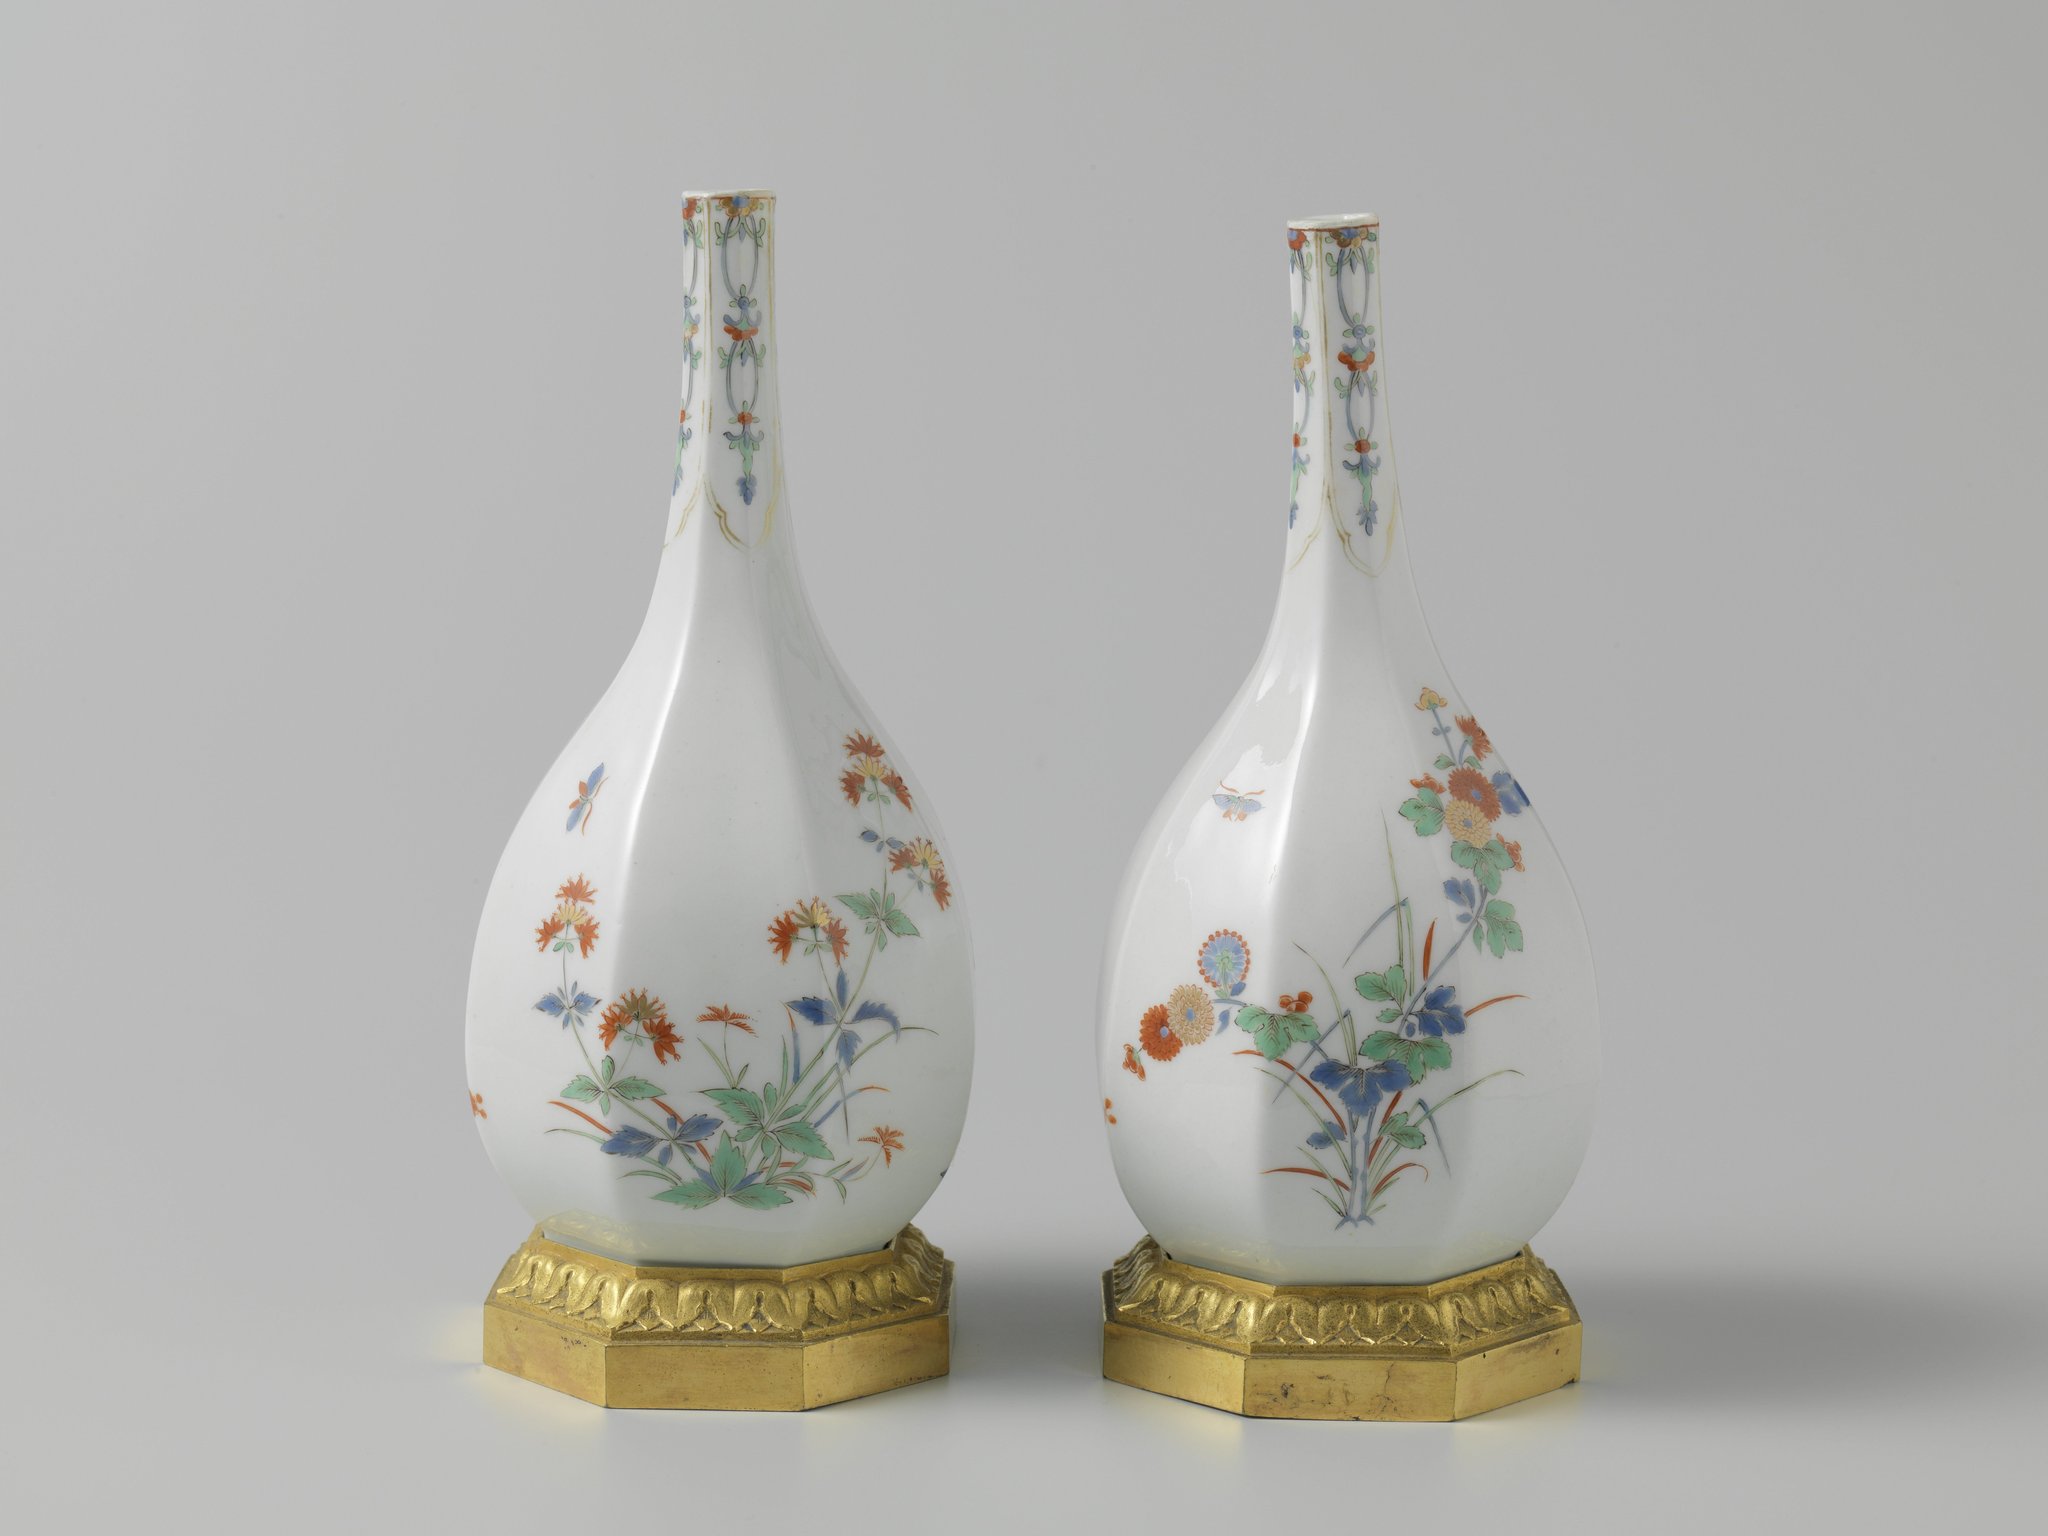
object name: bottle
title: Fles, veelkleurig beschilderd met een Kakiemon-decor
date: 1730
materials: porcelain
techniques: painted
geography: meissen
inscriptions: factory mark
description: Achthoekige fles van beschilderd porselein en een verguld bronzen montuur. De vaas heeft een slanke hals en is aan beide zijden beschilderd met bloeiende planten in kakiemon-stijl. De vaas is gemerkt.